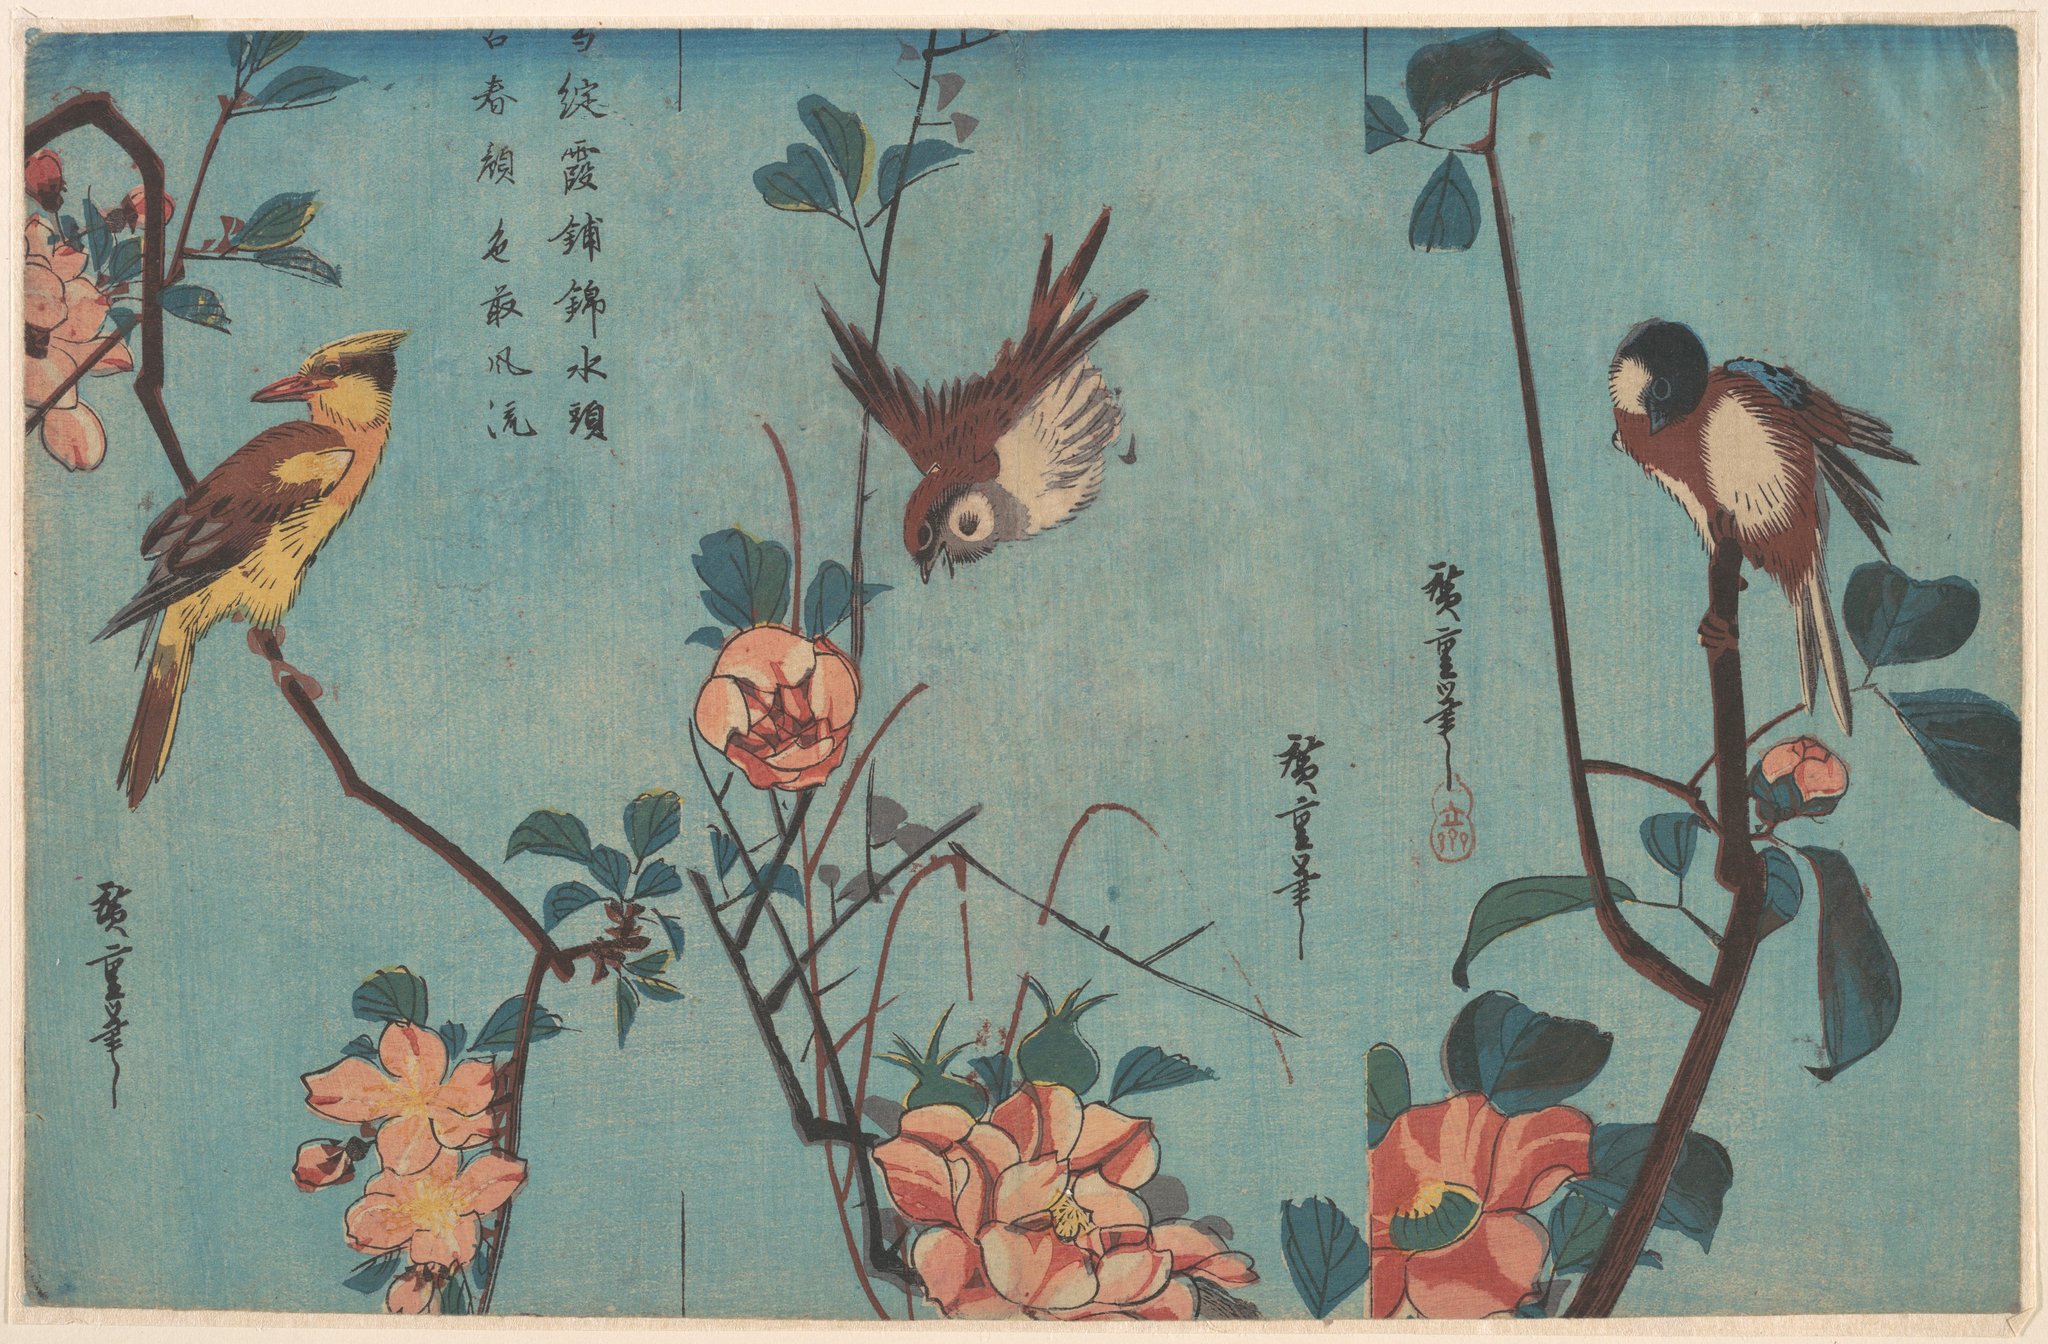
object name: print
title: Titmouse and Camellias (right), Sparrow and Wild Roses (center), and Black-naped Oriole and Cherry Blossoms (left)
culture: japanese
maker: utagawa hiroshige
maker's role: artist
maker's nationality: japanese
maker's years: 1797-1858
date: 1833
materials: ink, paper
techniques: woodblock print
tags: birds,flowers